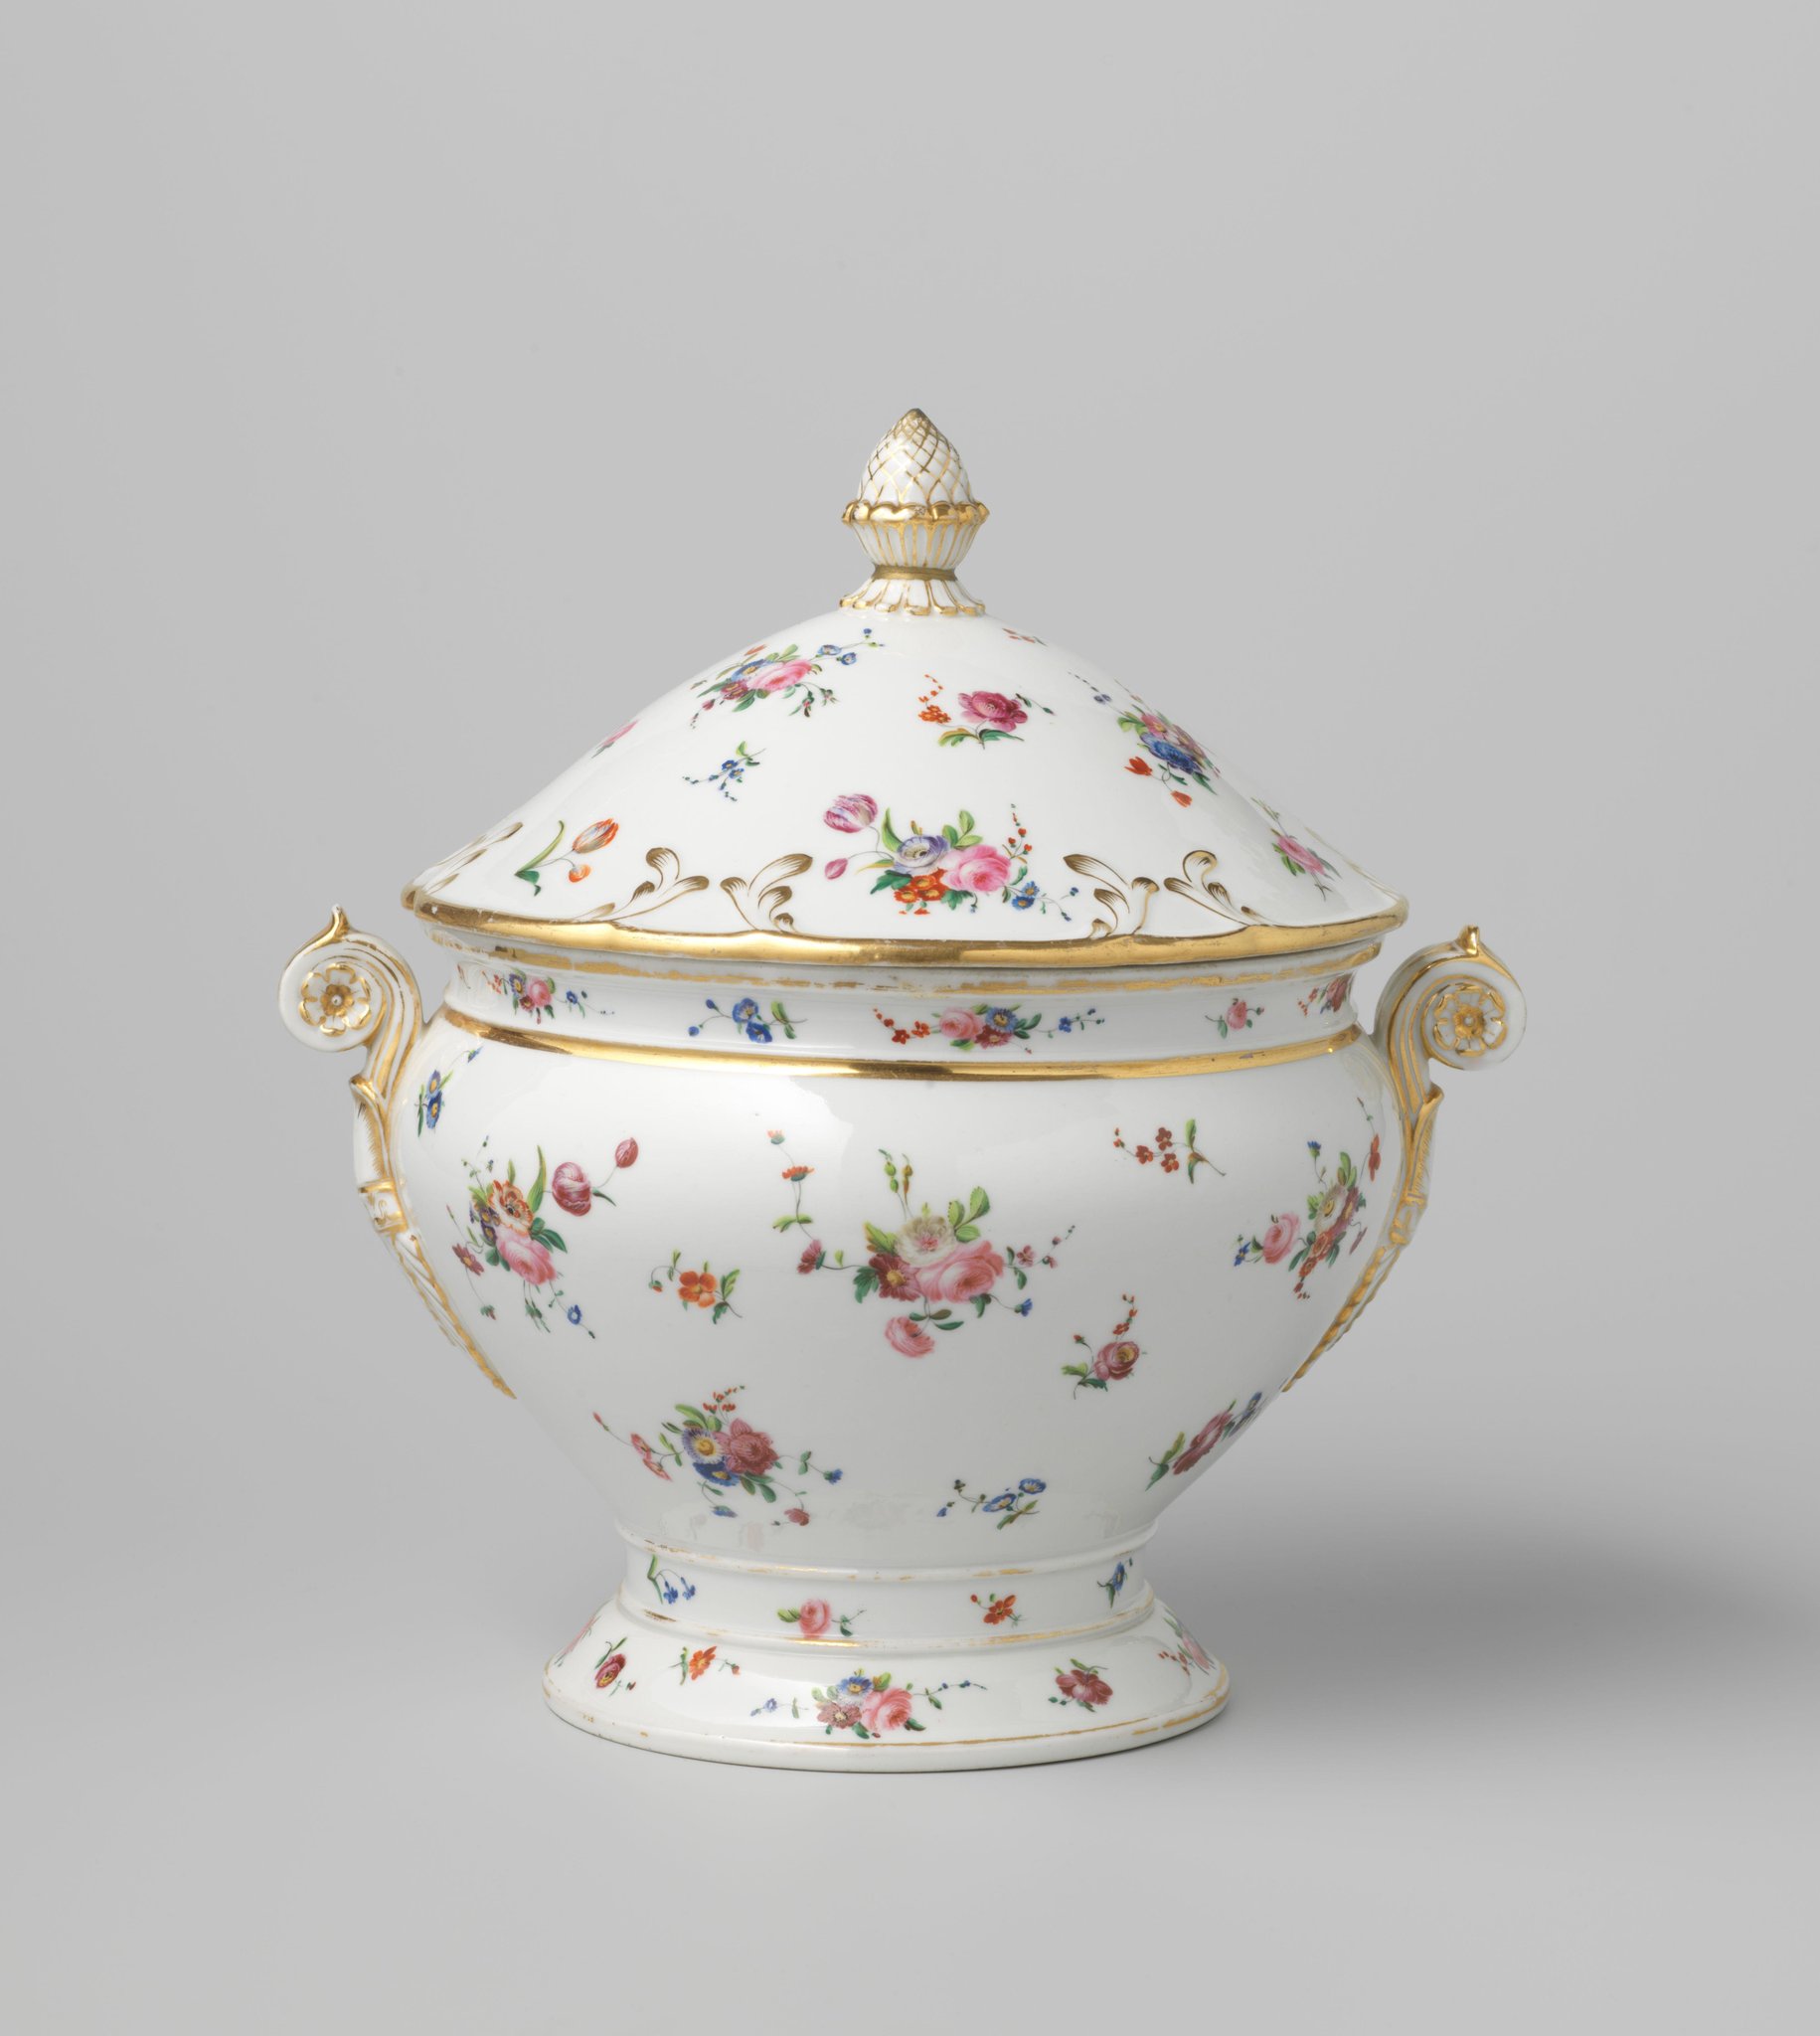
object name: tureen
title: Terrine with bouquets and flower sprays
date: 1839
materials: glaze, gold, paint, porcelain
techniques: firing, forming, gilding, turning, vitrification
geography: paris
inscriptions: mark: ‘DENUELLE/ Boulevard St. Denis 18/ à Paris’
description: Terrine van porselein met een gedrukt, eivormig lichaam, hoge, spreidende voet en iets spreidende rand. De terrine heeft twee handvatten in de vorm van een bladrank met een rozet in de krul en een palmet als basis. Beschilderd op het glazuur in blauw, rood, roze, groen, geel, paars, zwart en goud. Versierd met boeketten van verschillende bloemen en strooibloemen. Gemerkt op de onderzijde met 'DENUELLE/ Boulevard St. Denis 18/ à Paris'.